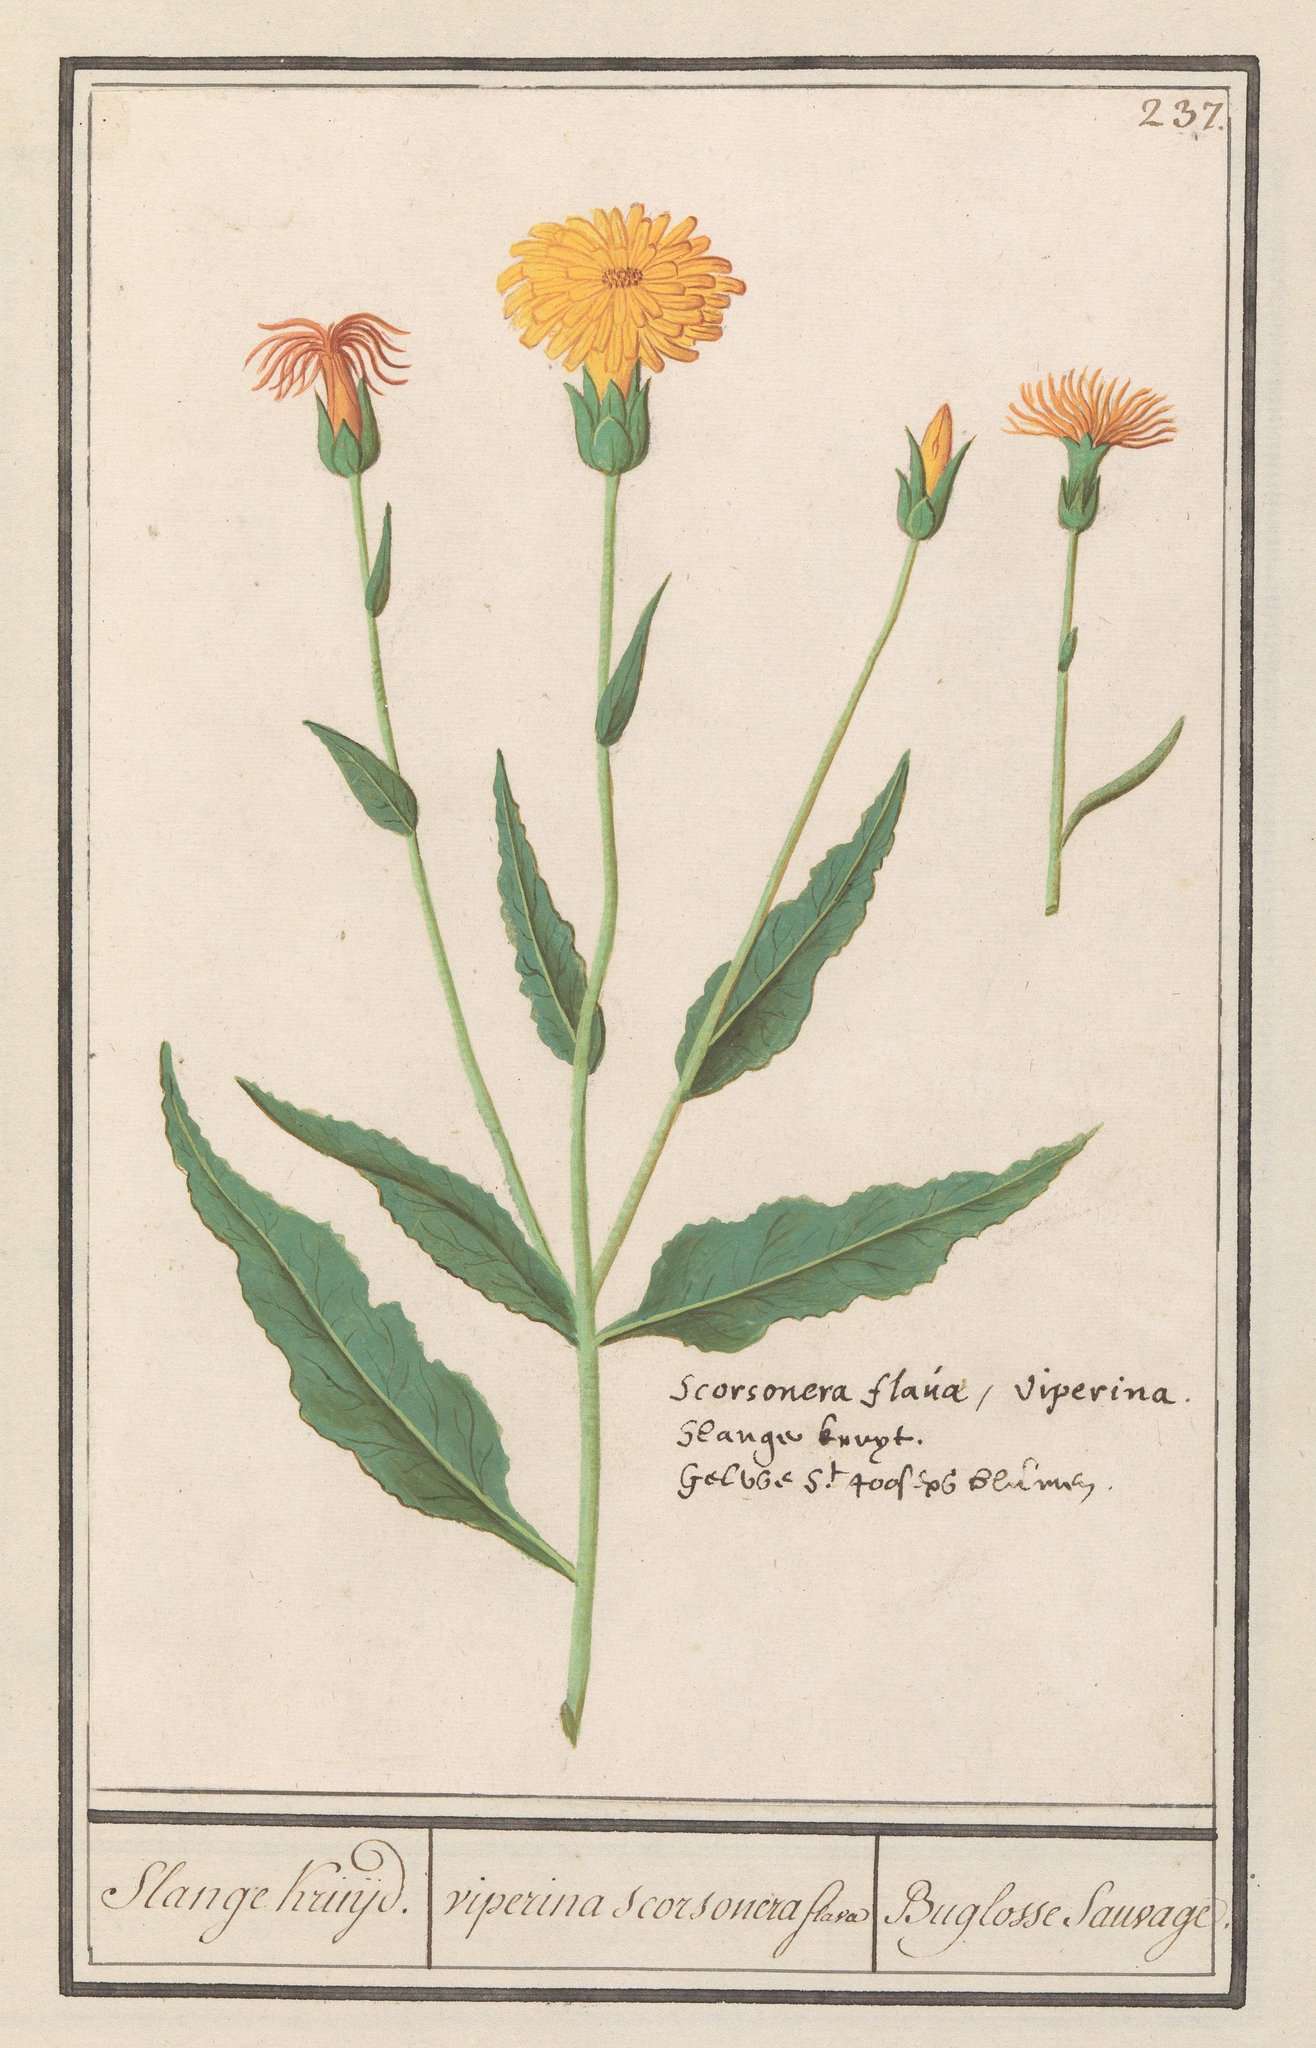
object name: drawing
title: Kleine schorseneer (Scorzonera humilis)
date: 1596-1610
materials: chalk, paint, ink, paper, watercolor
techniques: brush, pen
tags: flowers: scorzonera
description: Kleine schorseneer. Genummerd rechtsboven: 237. Rechtsonder de naam in drie talen. Onderdeel van het derde album met tekeningen van bloemen en planten. Tiende van twaalf albums met tekeningen van dieren, vogels en planten bekend rond 1600, gemaakt in opdracht van keizer Rudolf II. Met toelichting in Nederlands, Latijn en Frans.